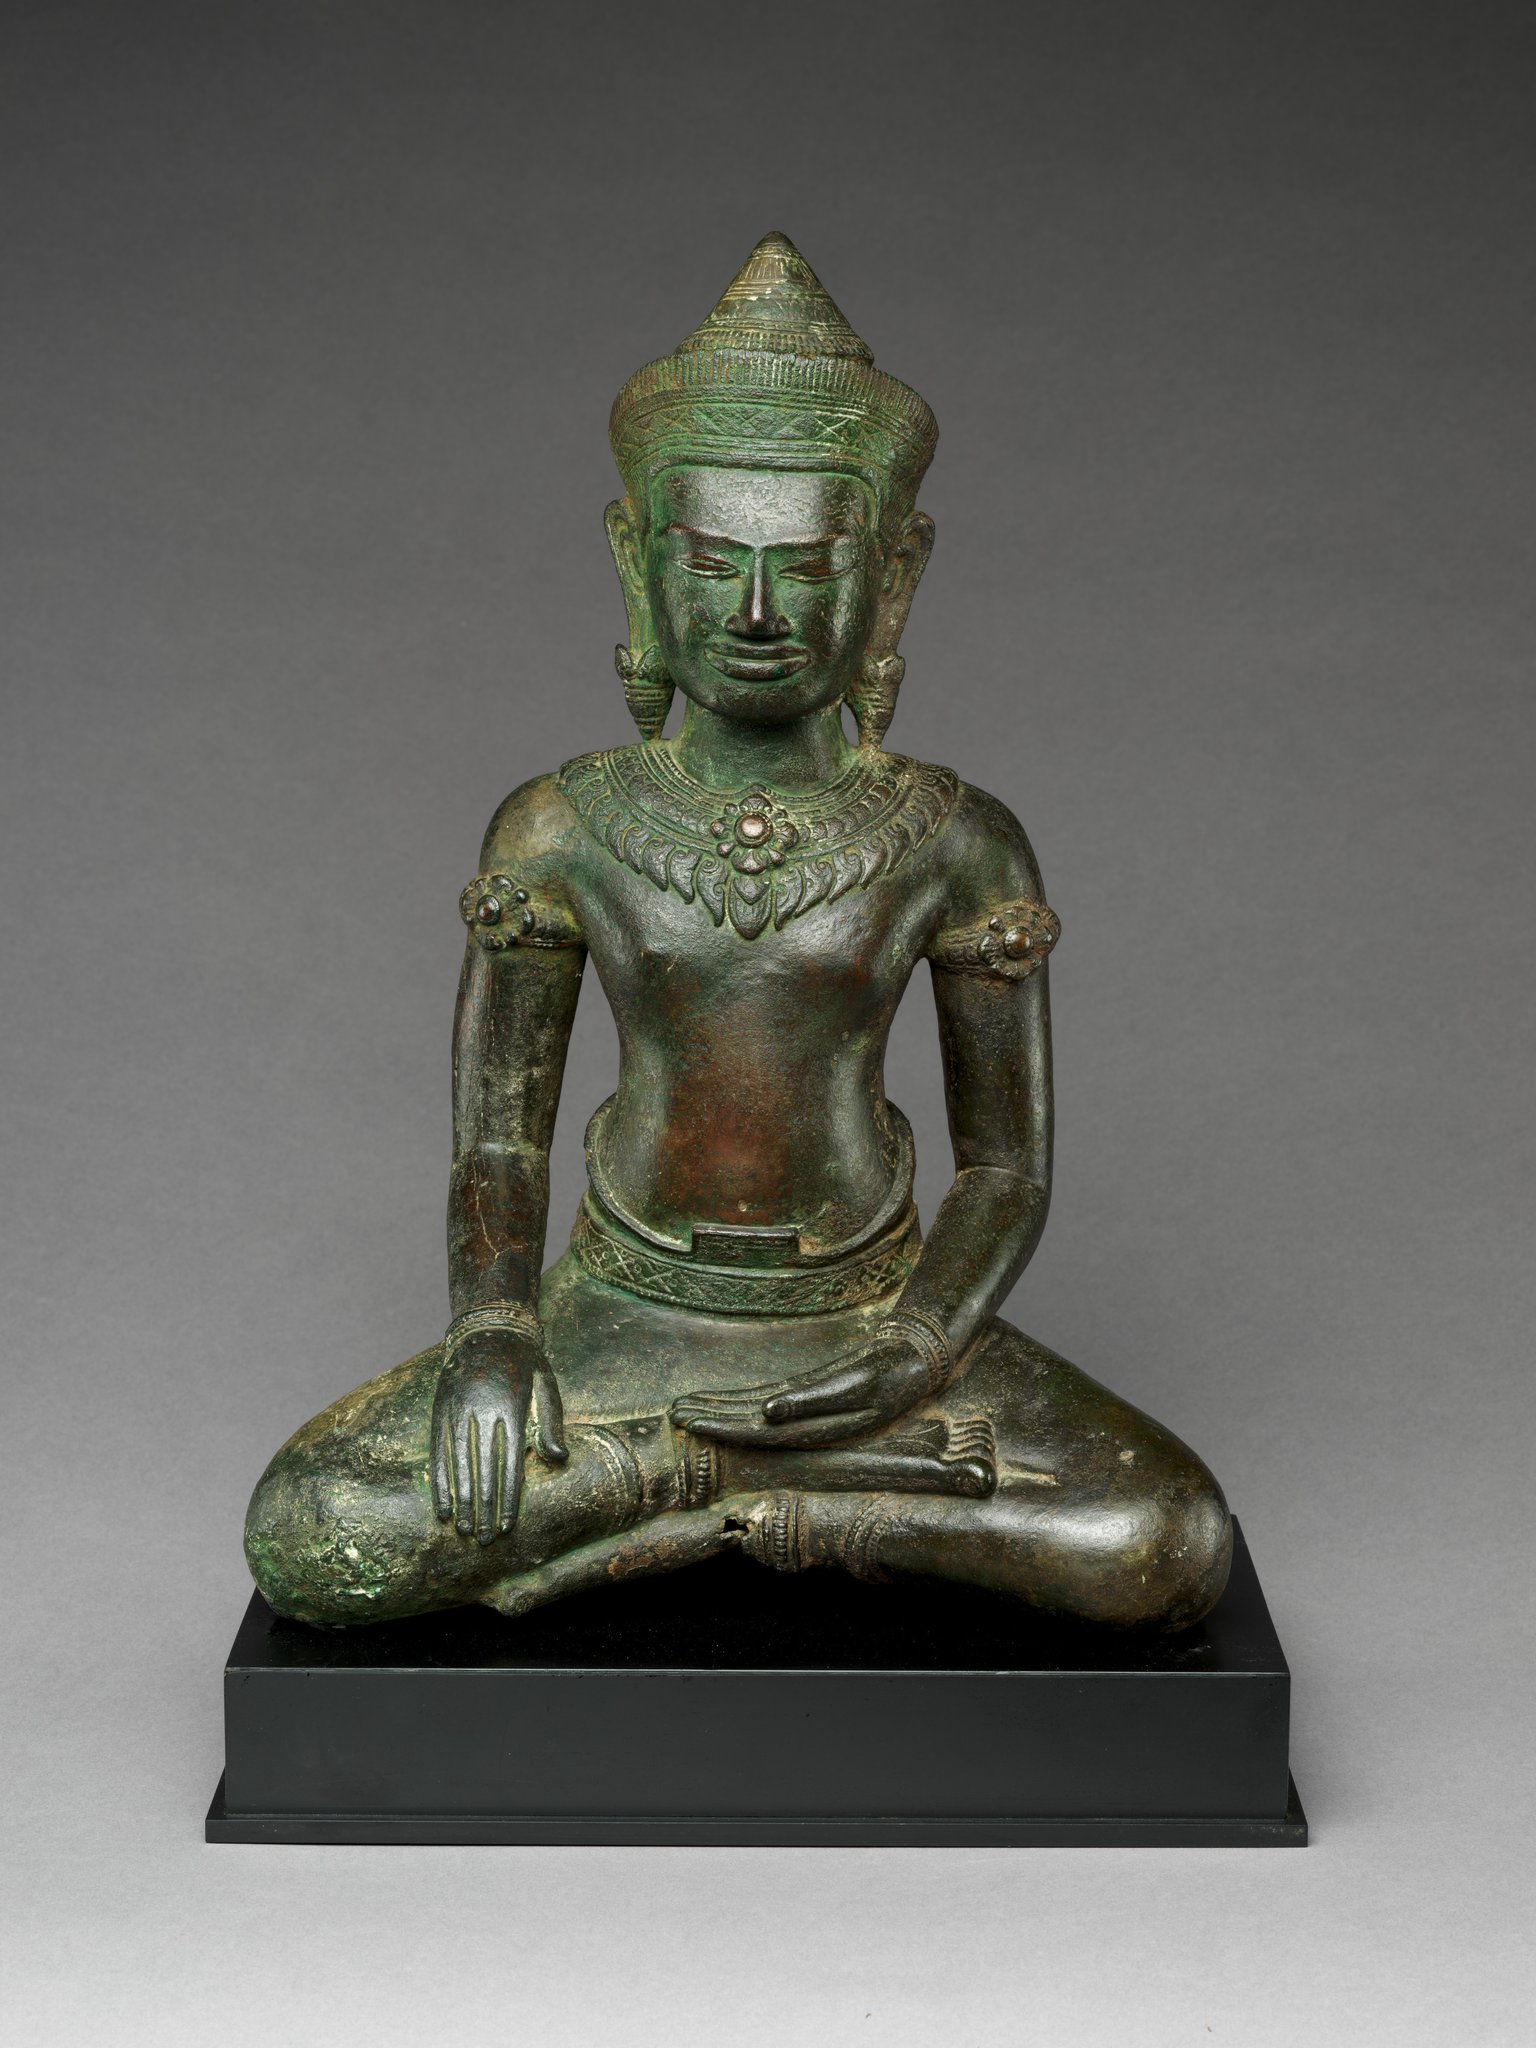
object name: figure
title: Crowned Buddha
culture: thai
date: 1101-1300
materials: copper alloy